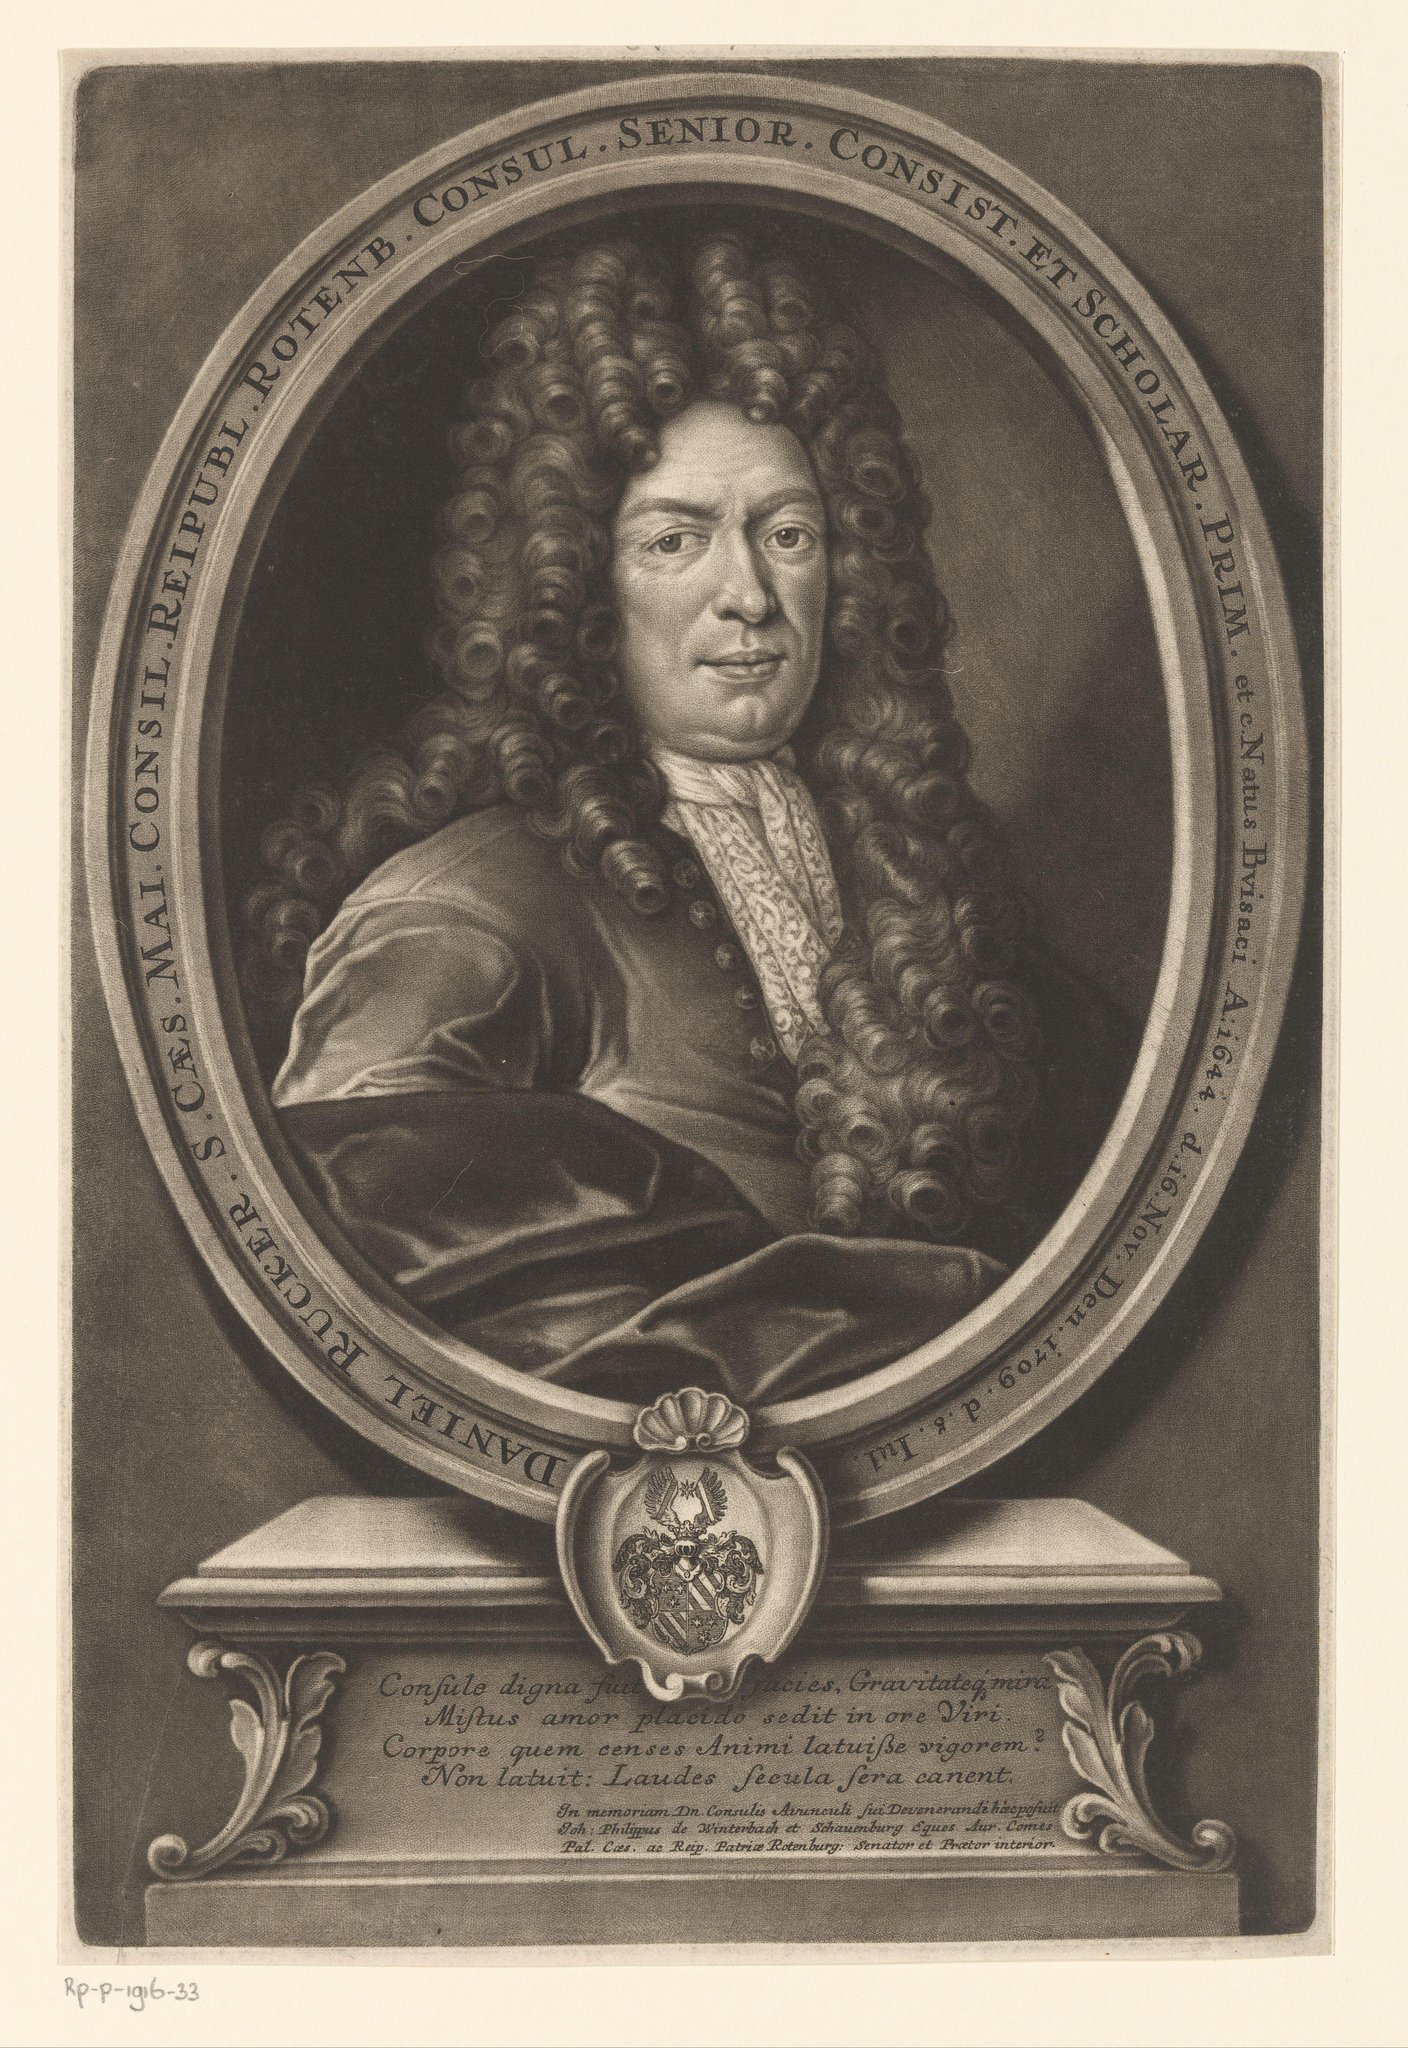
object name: print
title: Portret van Daniel Rücker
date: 1709-1731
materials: paper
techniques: etching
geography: augsburg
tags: historical persons, armorial bearing, heraldry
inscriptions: collector's mark: Lugt 2228